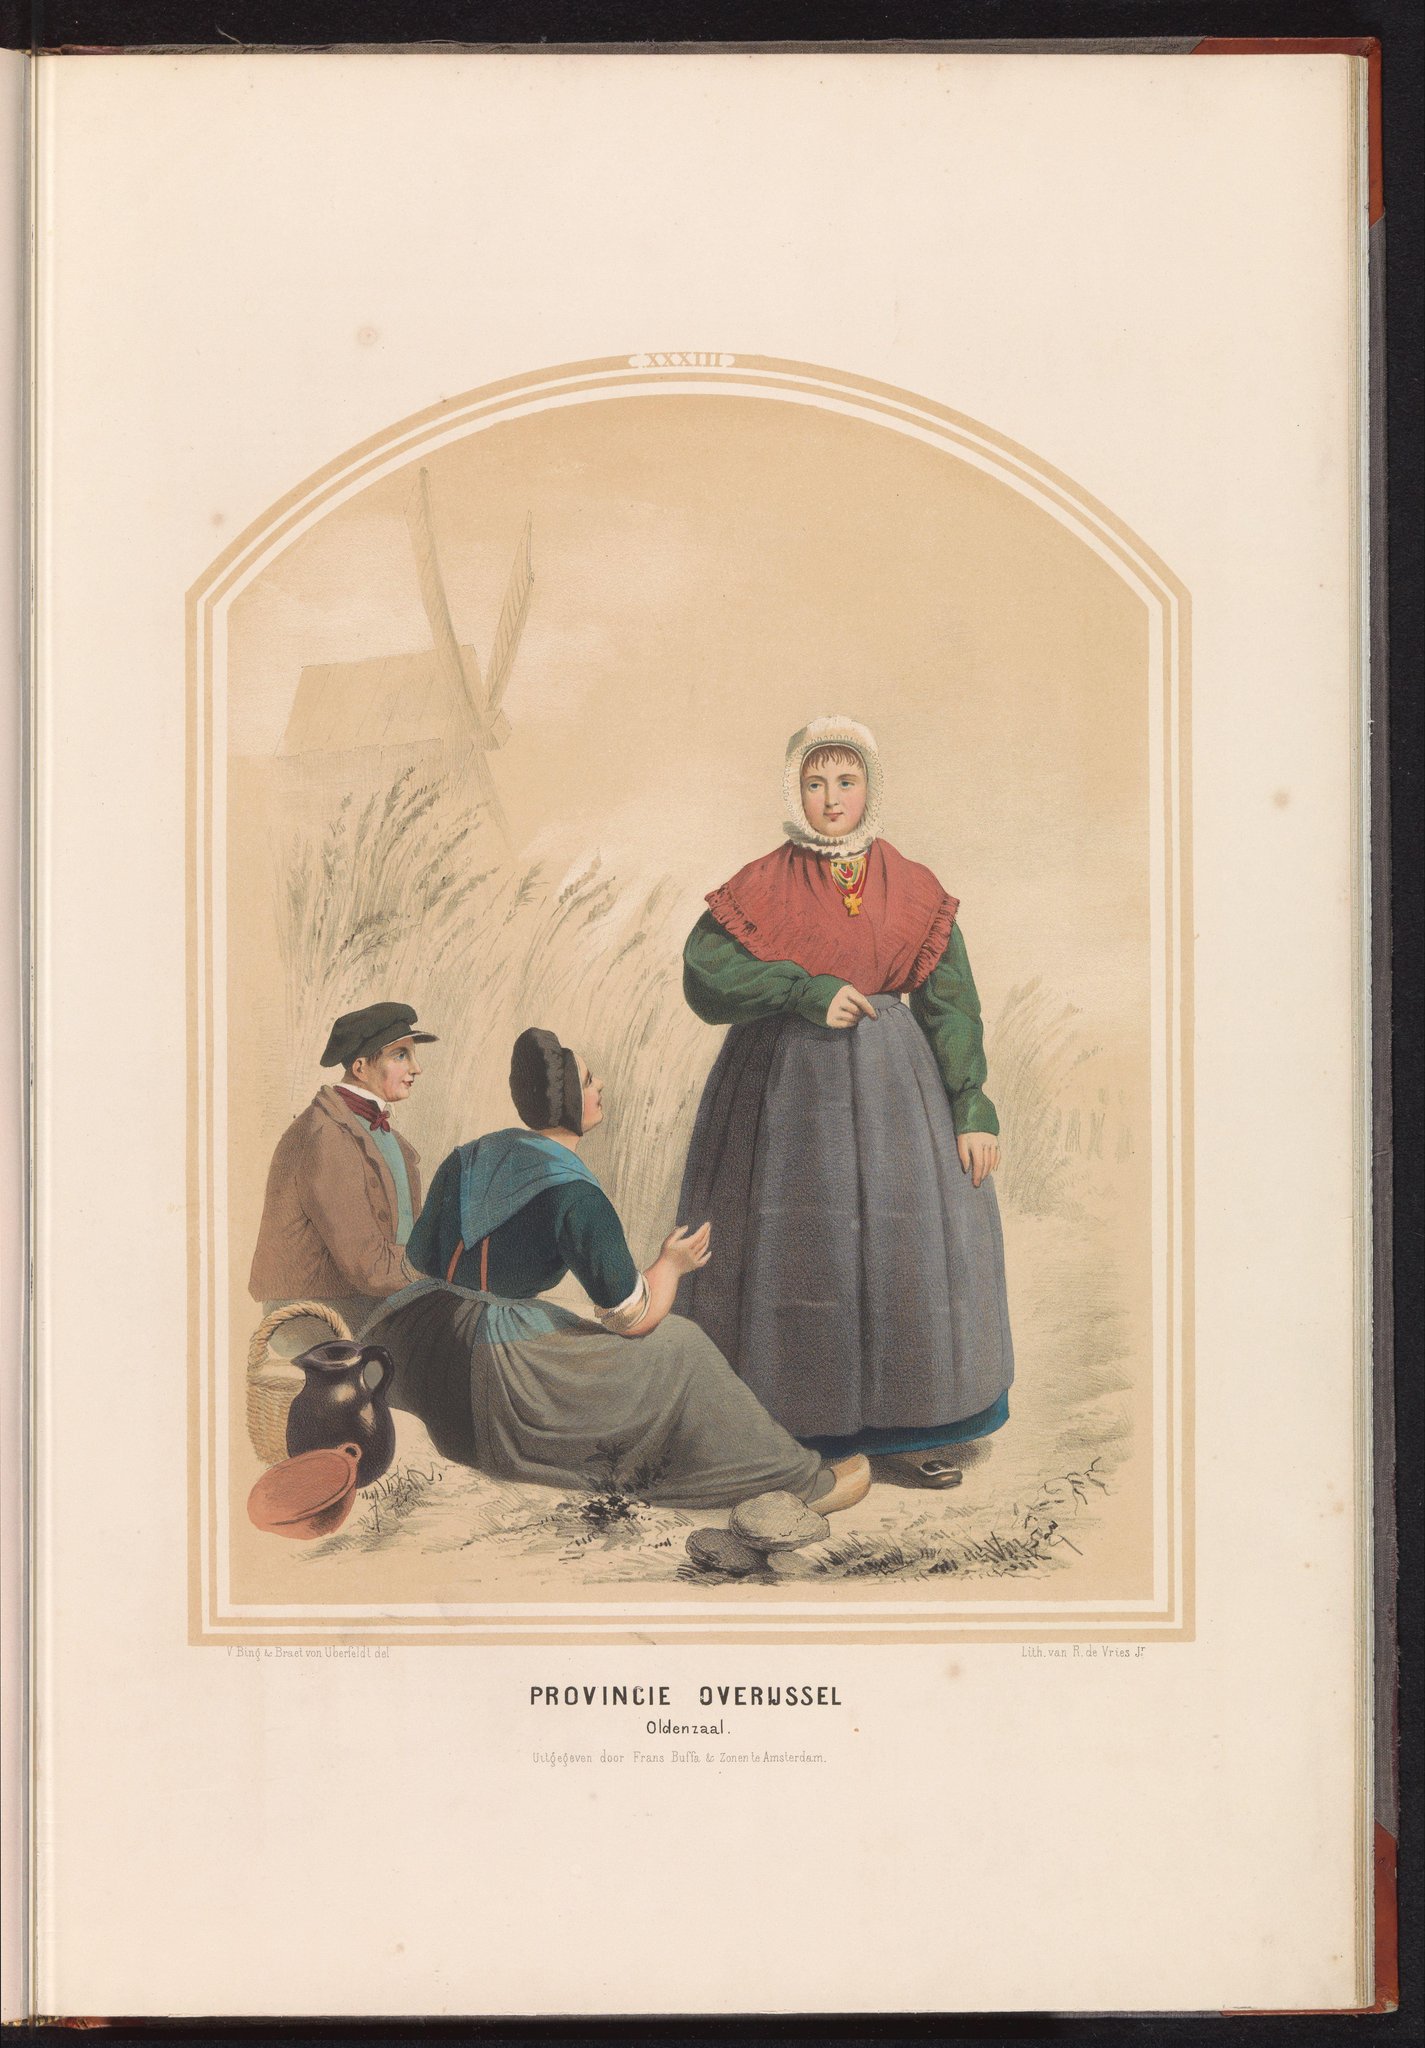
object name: print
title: Klederdracht van Oldenzaal in Overijssel, 1857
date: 1857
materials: paper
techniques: hand coloring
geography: netherlands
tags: folk costume, regional costume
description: Klederdracht van Oldenzaal in de provincie Overijssel. Een man en twee vrouwen. Illustratie in een boek uit 1857 met 56 platen van Nederlandse klederdrachten.